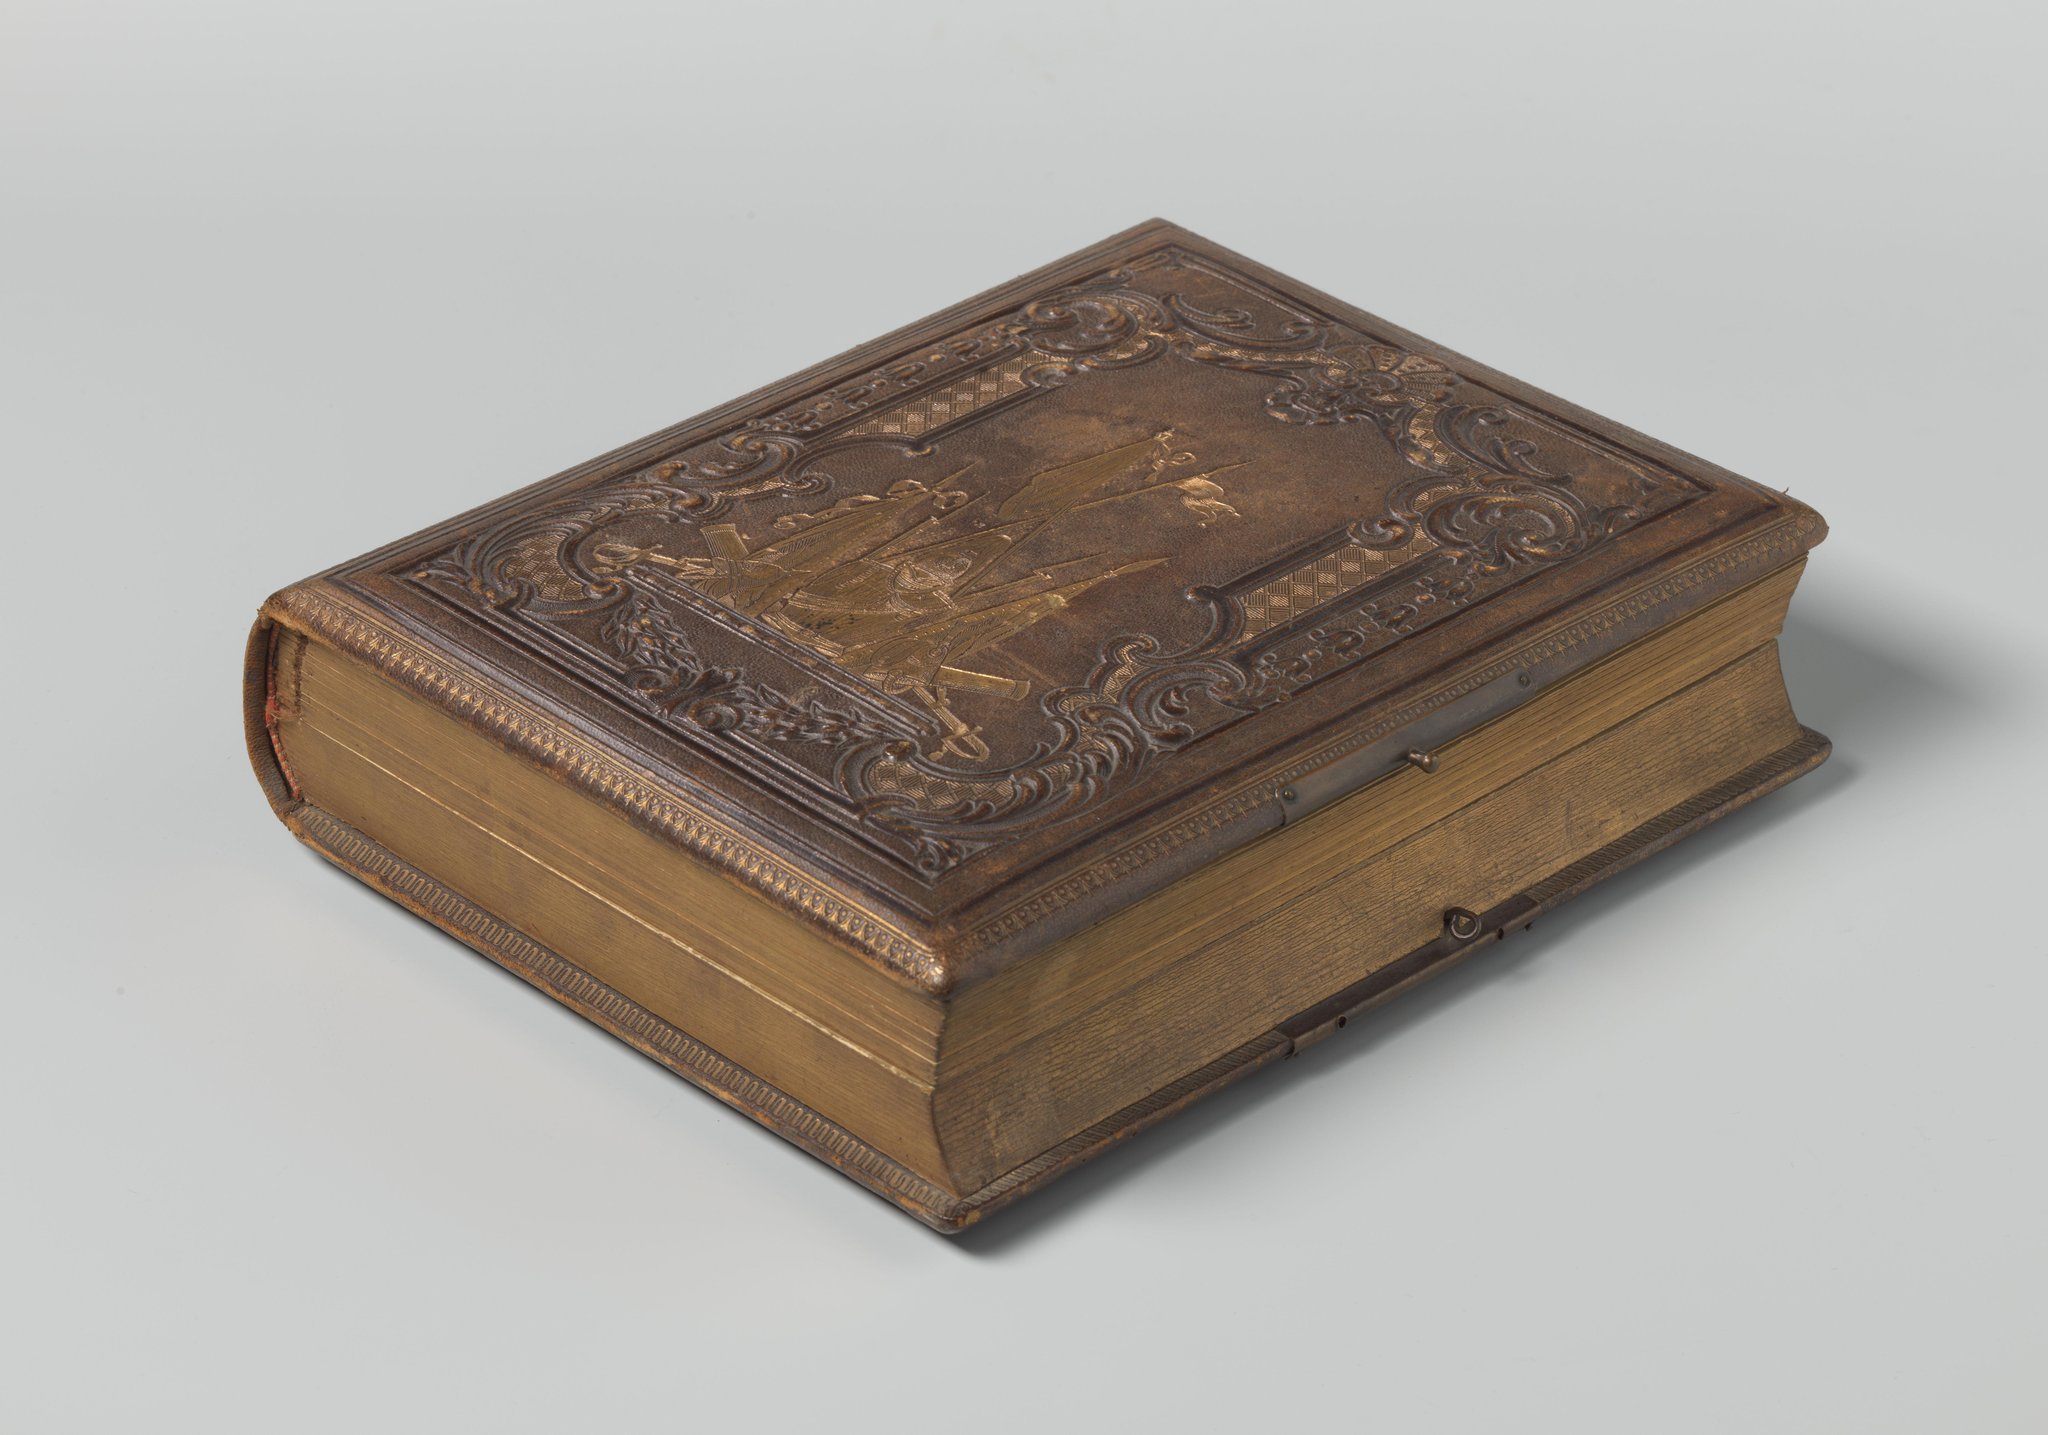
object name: slip in album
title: Fotoalbum met speeldoos met zeven foto's van Britse militairen en een prentbriefkaart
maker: Anonymous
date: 1870-1920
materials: cardboard, leather, metal, paper, photographic support, wood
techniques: albumen print, lithograph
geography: england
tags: ranks in the army, historical persons, (military) uniforms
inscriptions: collector's mark: ‘DIENST/ VERSPREIDE/ RIJKSKOLLEKTIES/ (...) A 653’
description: Fotoalbum met dertien pagina's met in totaal acht foto's. Het album bevat twee kabinetfoto's en vijf cartes-de-visite in met gouden lijnen of voorstellingen in kleurenlithografie omkaderde passe-partouts en één losse prentbriefkaart. Niet alle passe-partouts zijn gevuld. Achterin het album bevindt zich een speeldoos, die met de sluiting kon worden geactiveerd. Afgebeeld zijn portretten van Britse militairen. De foto's zijn gemaakt door diverse fotografen, in Engeland en India. Van één foto is de fotograaf anoniem.